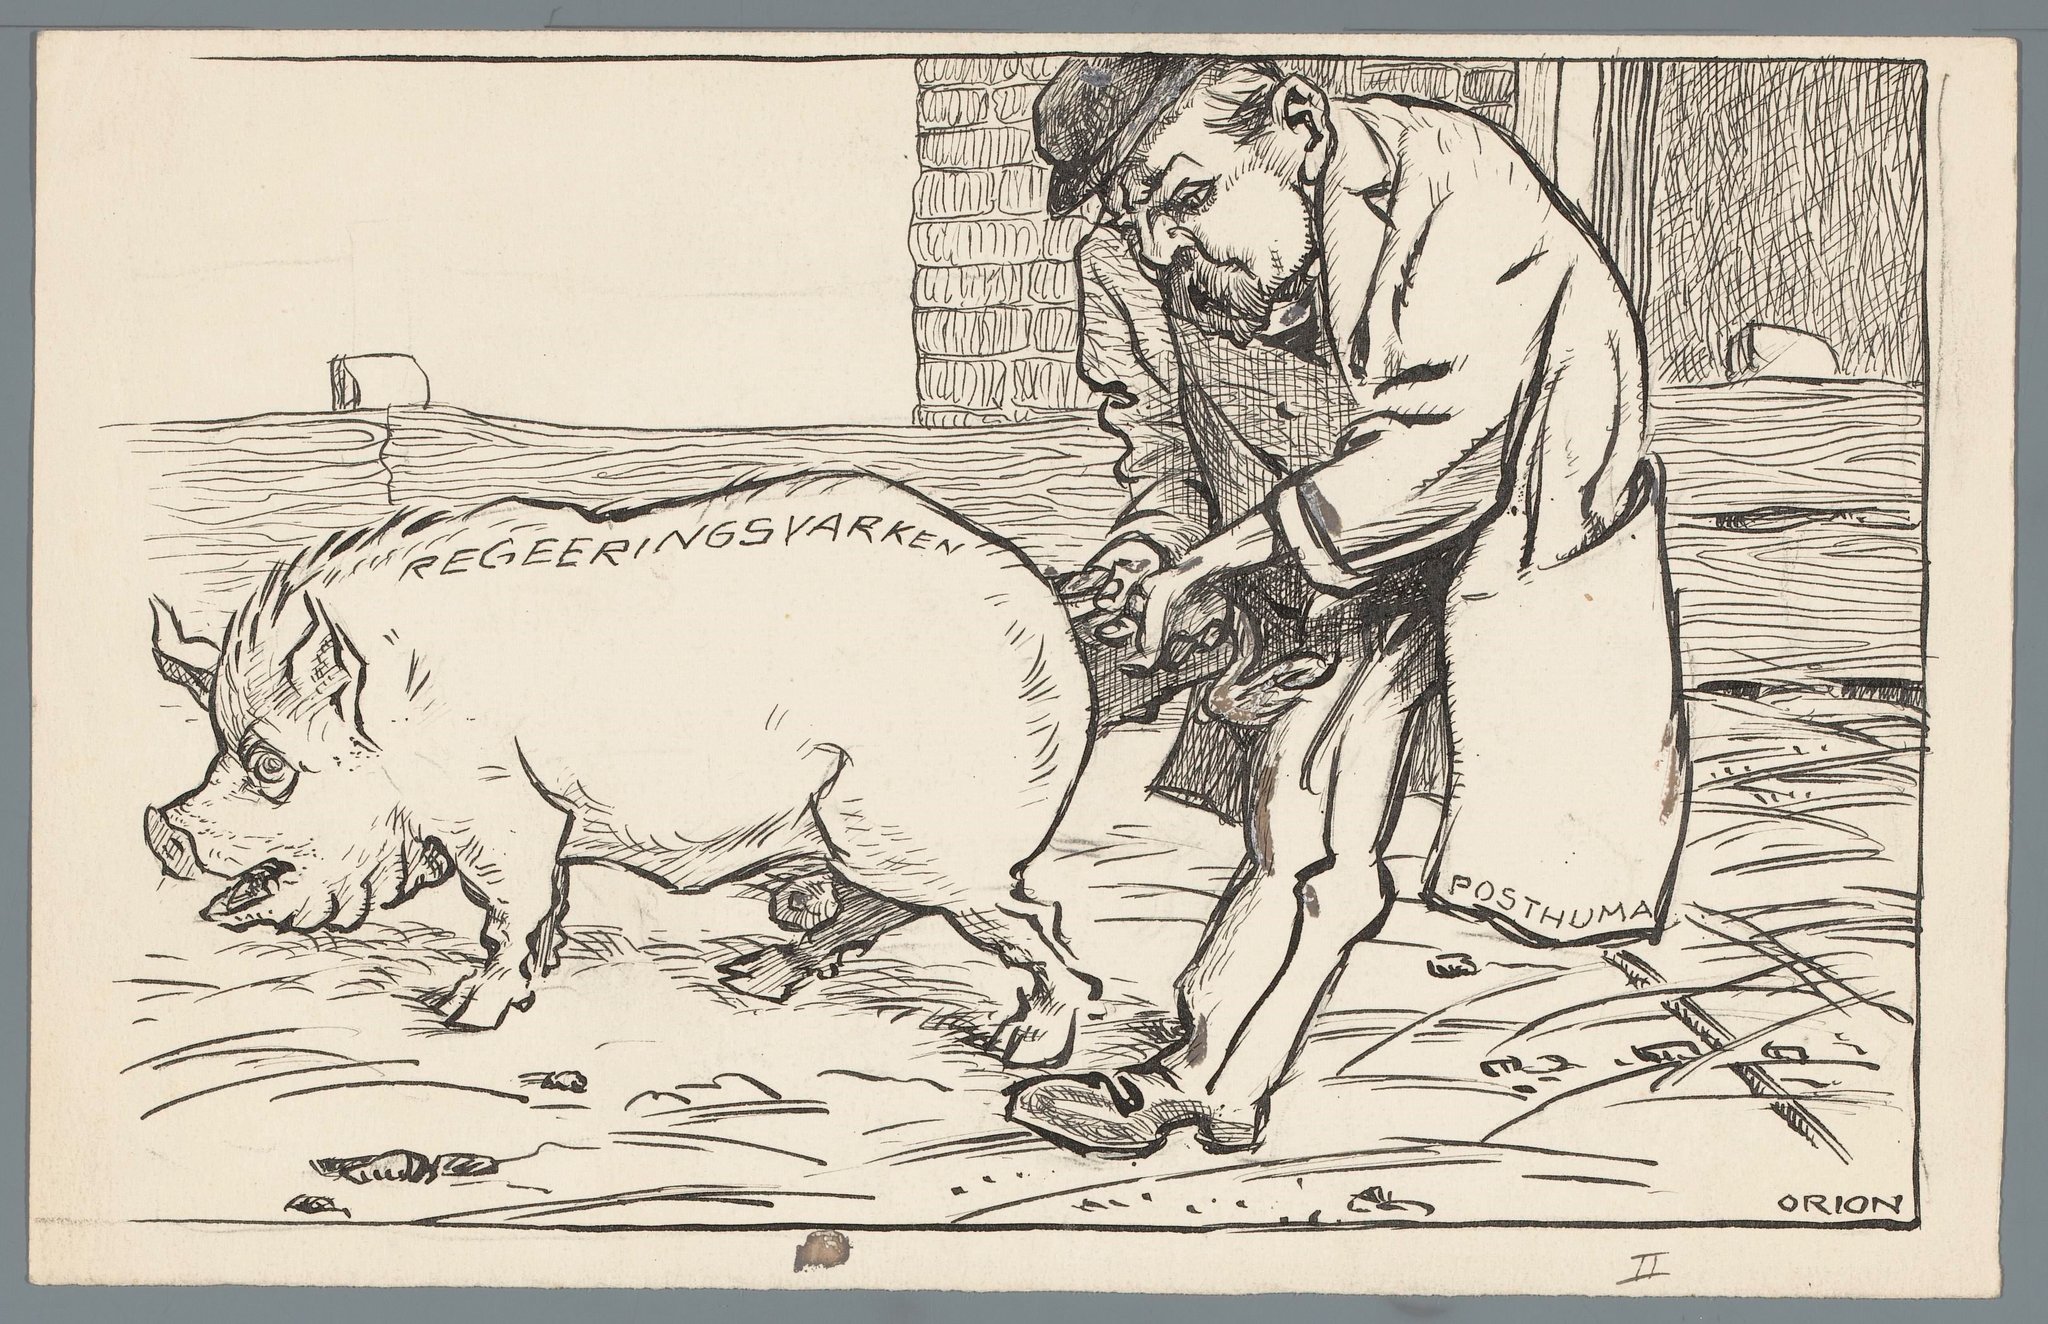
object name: drawing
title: Minister Postuma en het regeringsvarken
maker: patricq kroon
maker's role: draughtsman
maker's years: 1862-1941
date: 1914-1918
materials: ink, paper, pencil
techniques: pen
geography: netherlands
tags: politician, pig, political caricatures and satires, netherlands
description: Minister Folkert Posthuma als boer trekt aan de staart van een varken aangeduid als het 'regeeringsvarken'. Ontwerp voor een politieke spotprent.